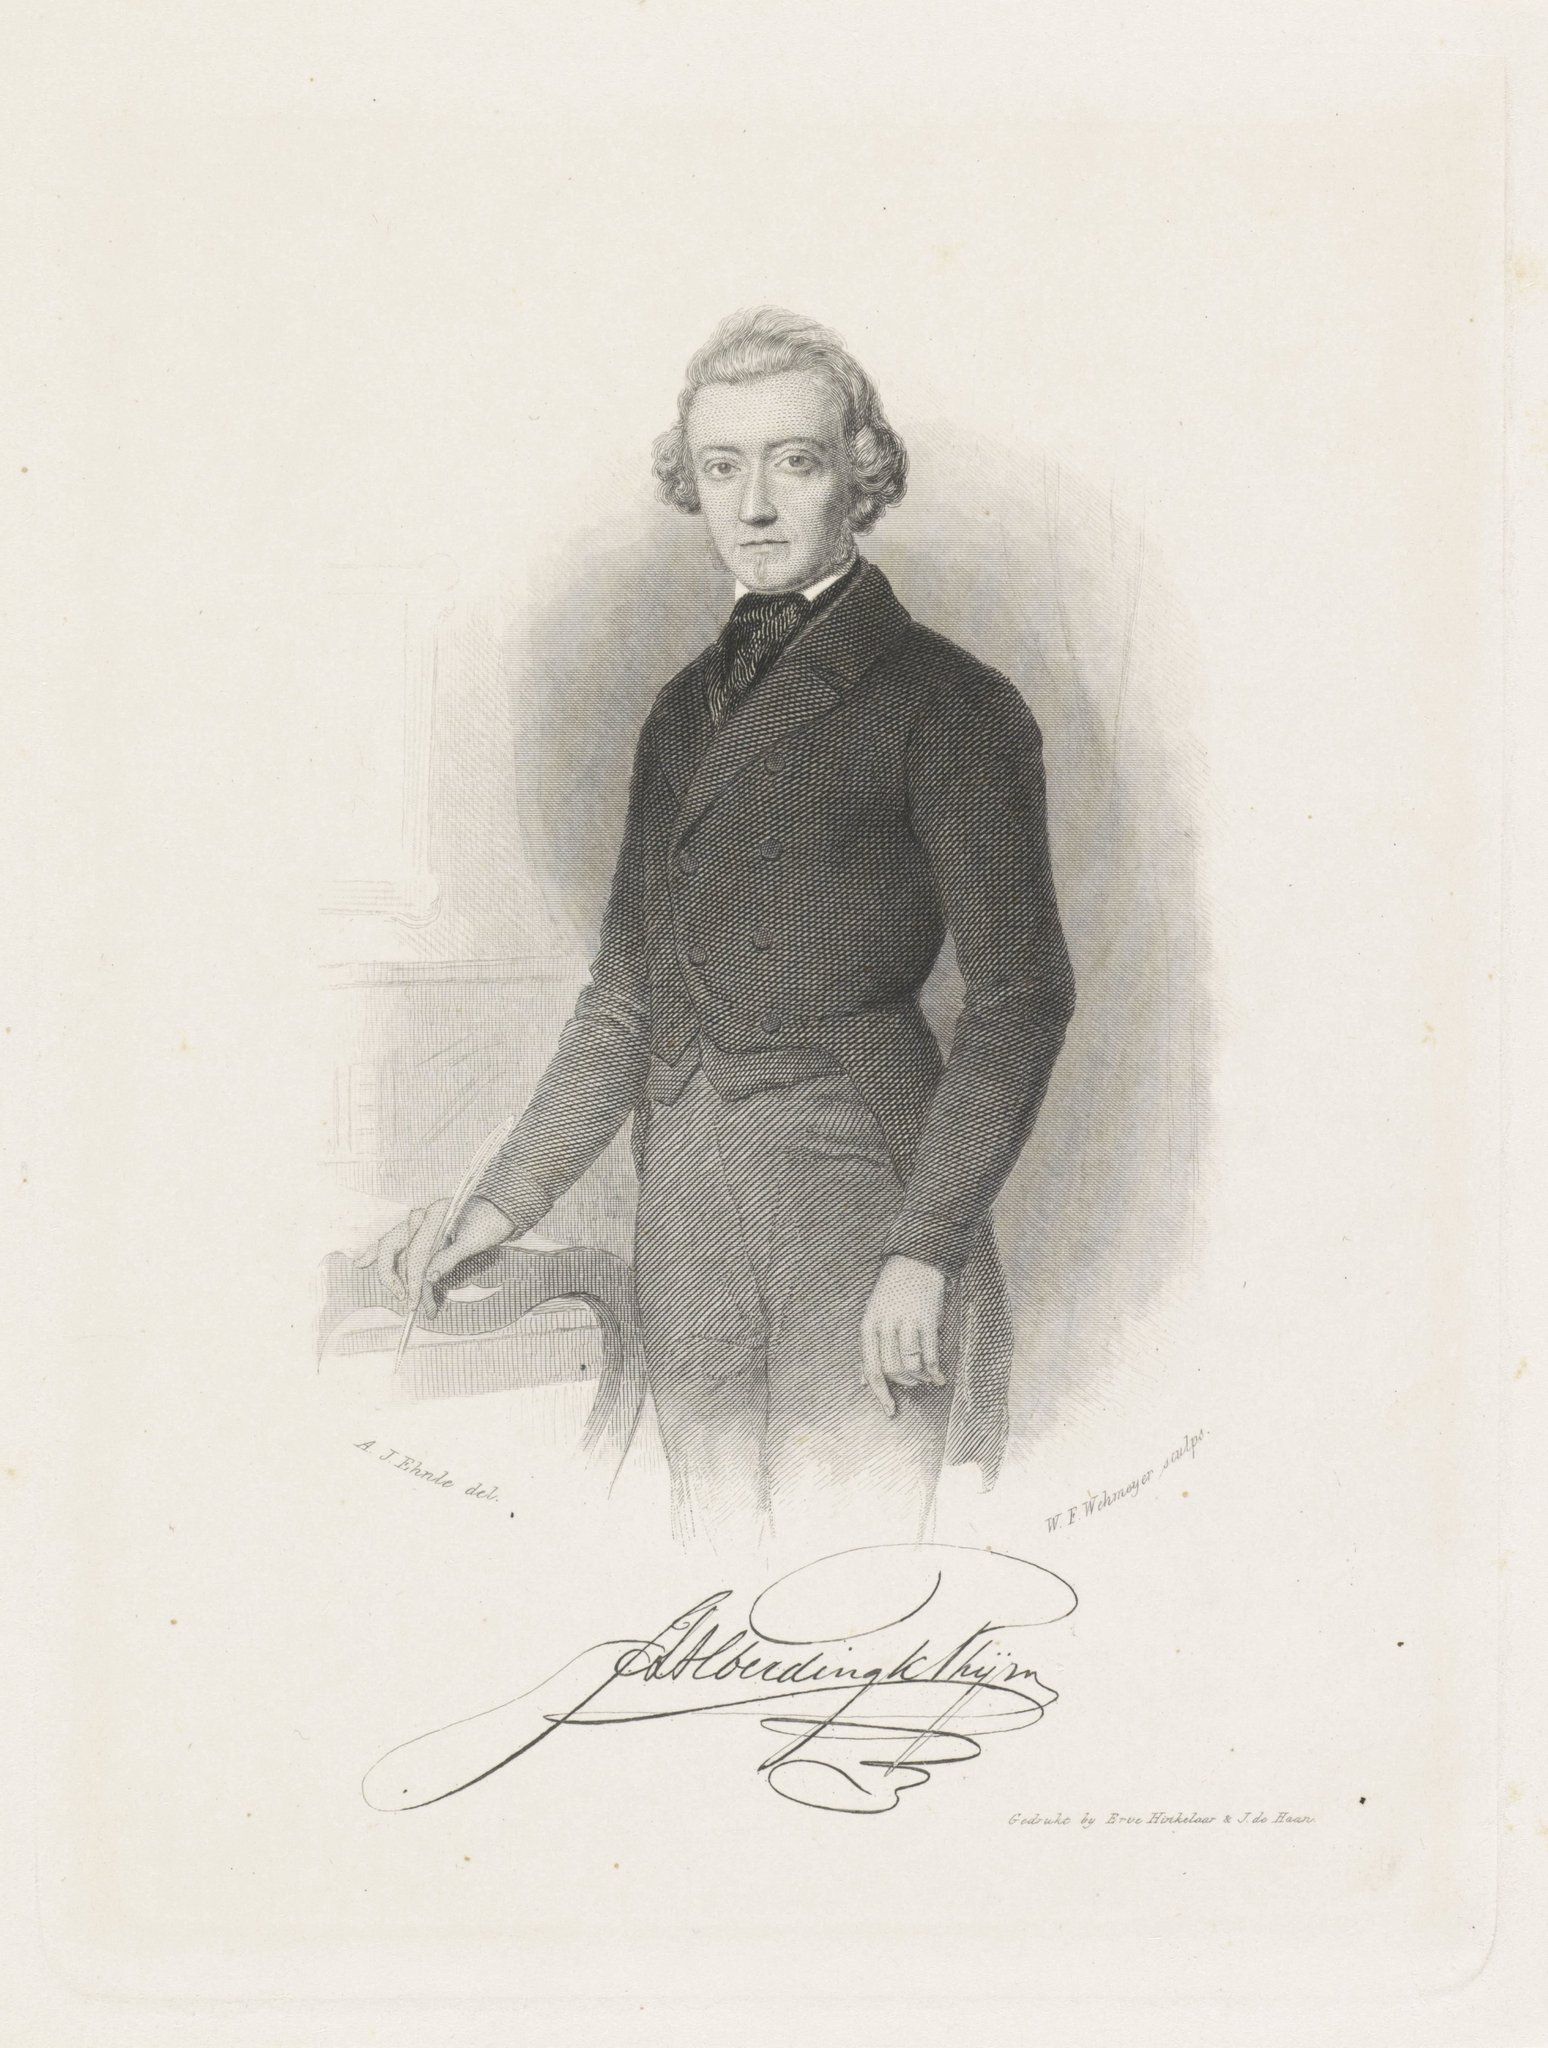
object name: print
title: Portret van Joseph Albertus Alberdingk Thijm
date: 1834-1877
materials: paper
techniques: engraving, etching, roulette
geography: amsterdam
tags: amsterdam, painter, draughtsman, publisher, josephus albertus alberdingk thijm, adult man, historical persons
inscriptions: collector's mark: Lugt 2228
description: Portret van Joseph Albertus Alberdingk Thijm, auteur. Onder de voorstelling de signatuur van de geportretteerde.